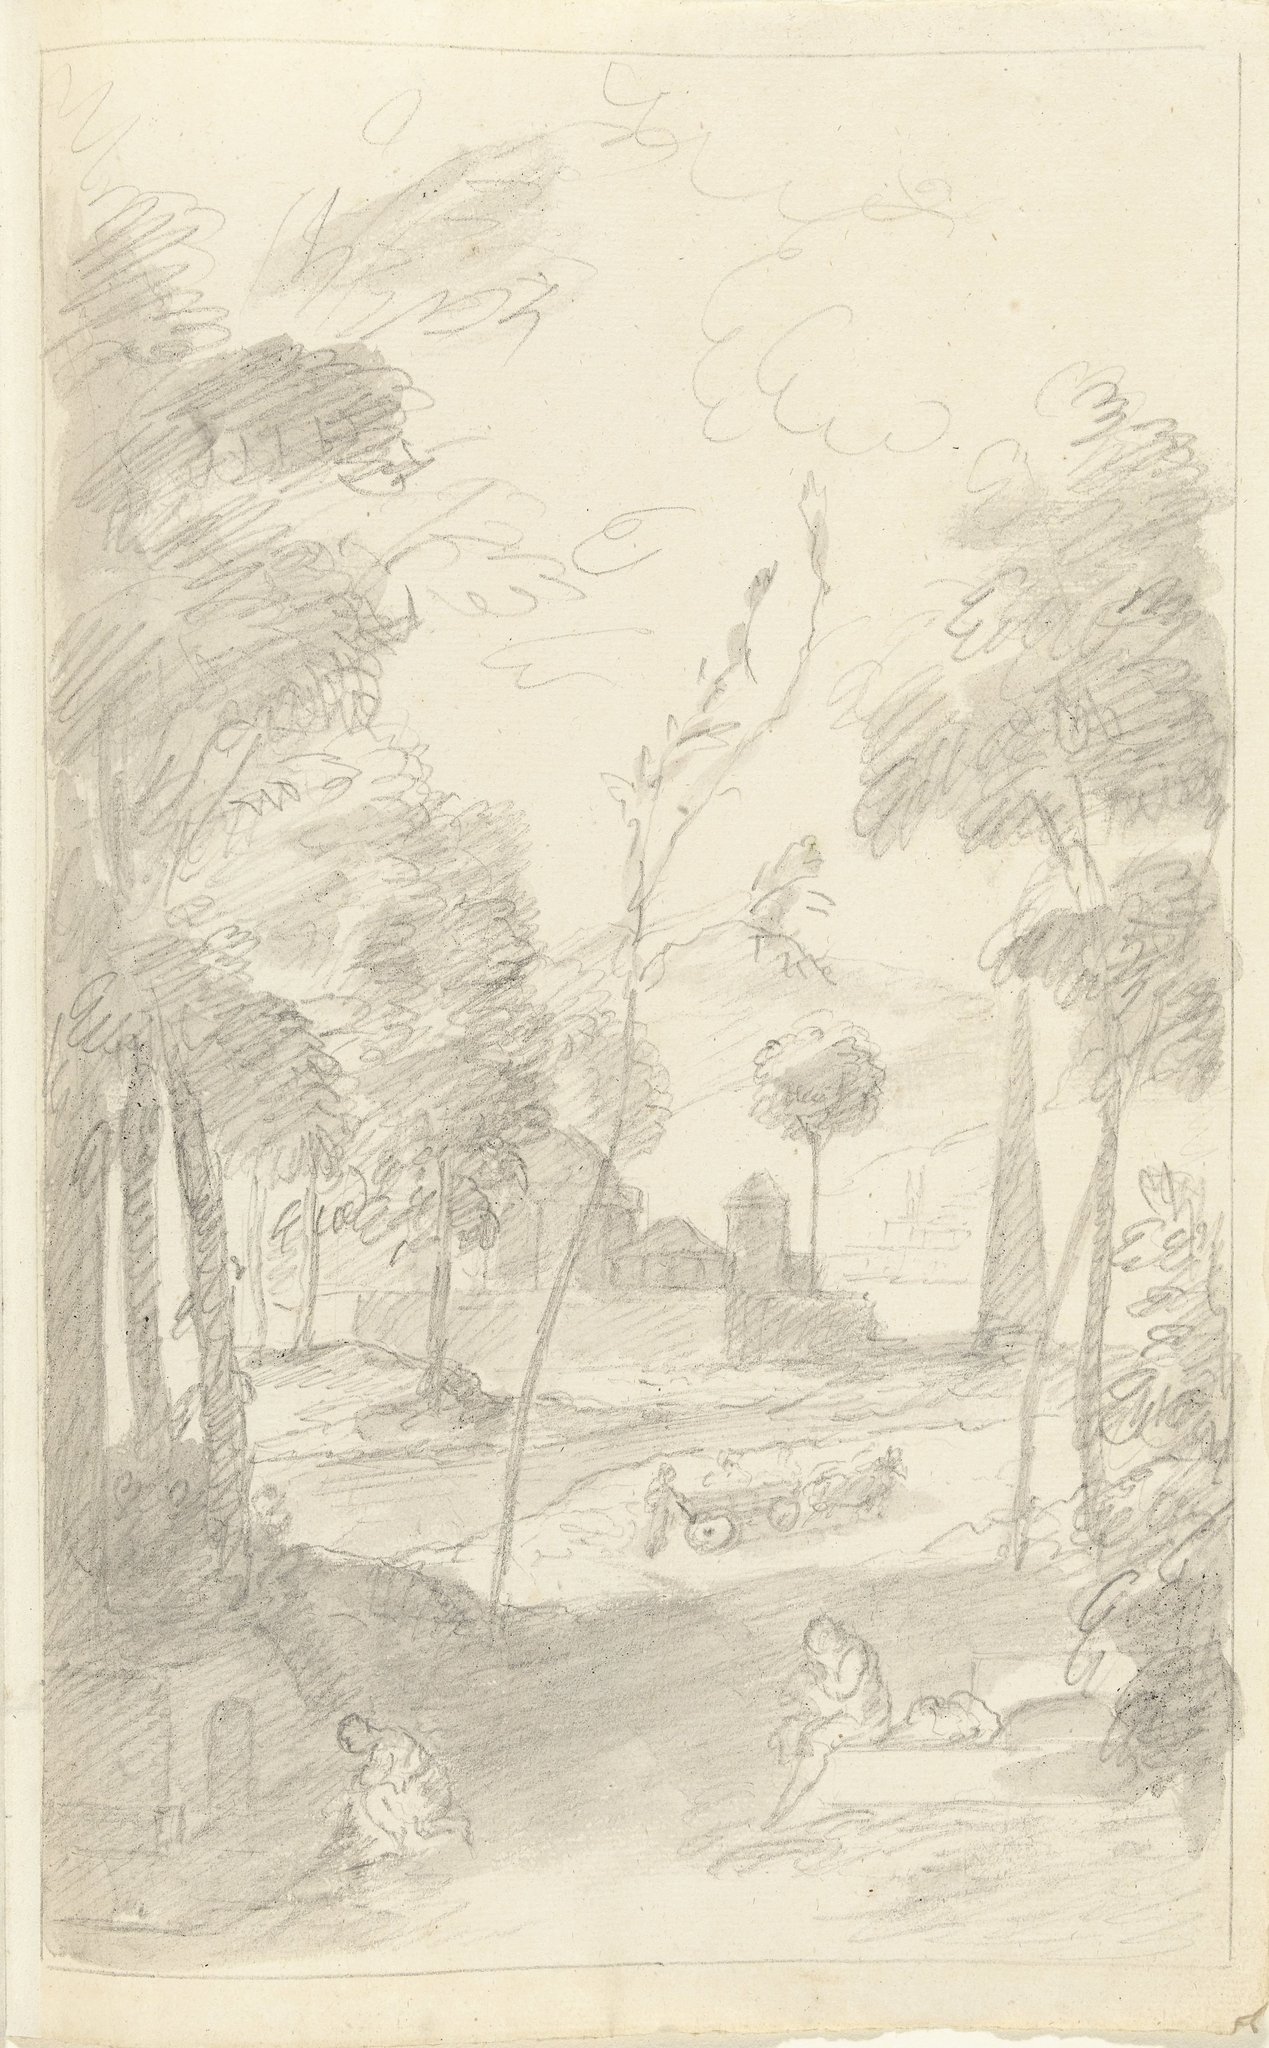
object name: drawing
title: Arcadisch landschap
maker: dionys van nijmegen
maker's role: draughtsman, painter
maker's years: 1705-1798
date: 1715-1798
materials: paper, pencil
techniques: brush